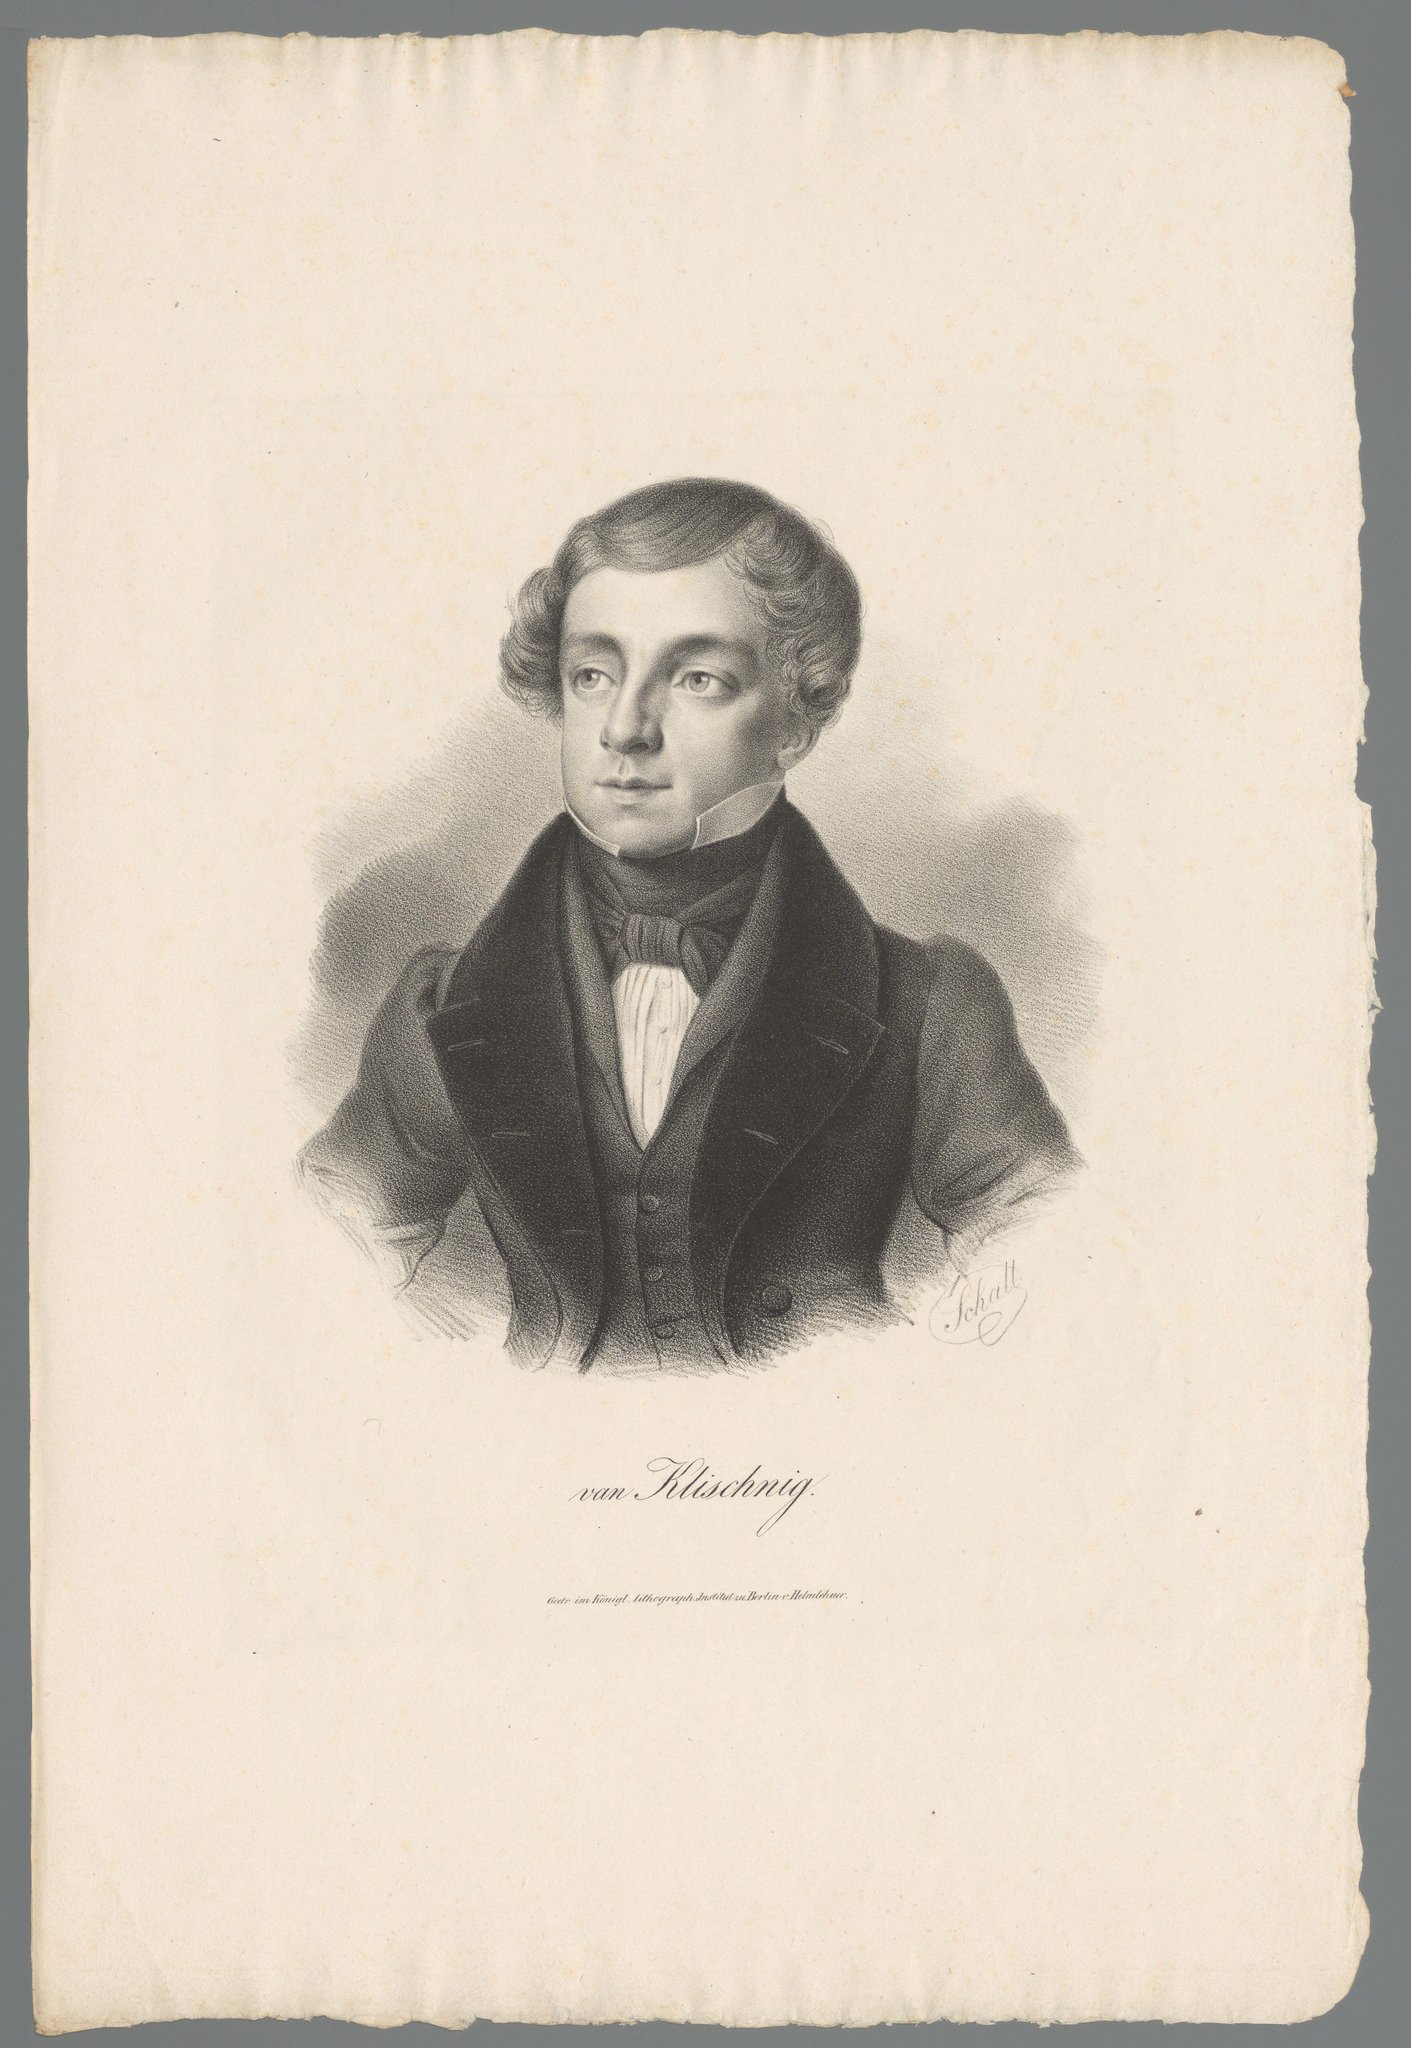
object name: print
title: Van Klischnig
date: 1820-1865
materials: paper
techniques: lithograph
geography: berlin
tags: adult man, historical persons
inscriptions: collector's mark: Lugt 2228